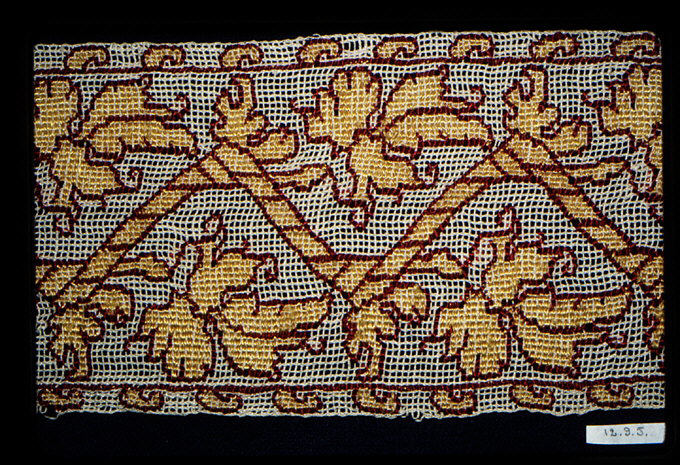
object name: band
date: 1601-1700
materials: silk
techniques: embroidery